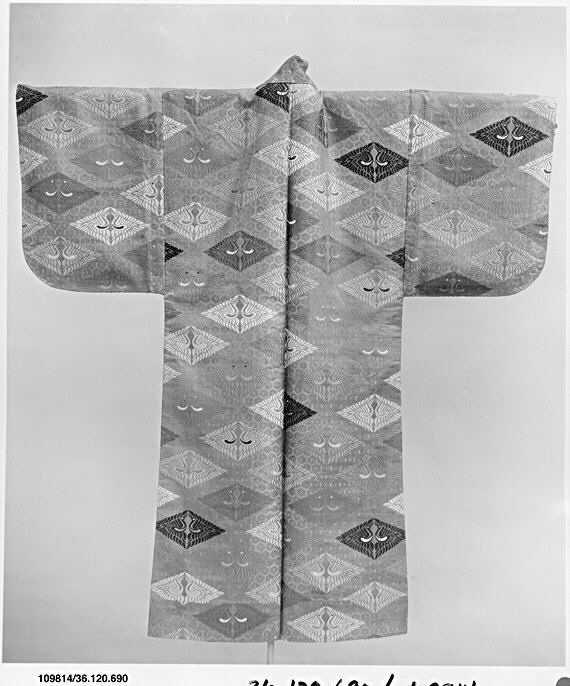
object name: noh robe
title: Noh Robe (Karaori) with Tortoise Shell Pattern and Crane Lozenges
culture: japanese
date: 1801-1850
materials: silk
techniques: brocade, patterning, weave